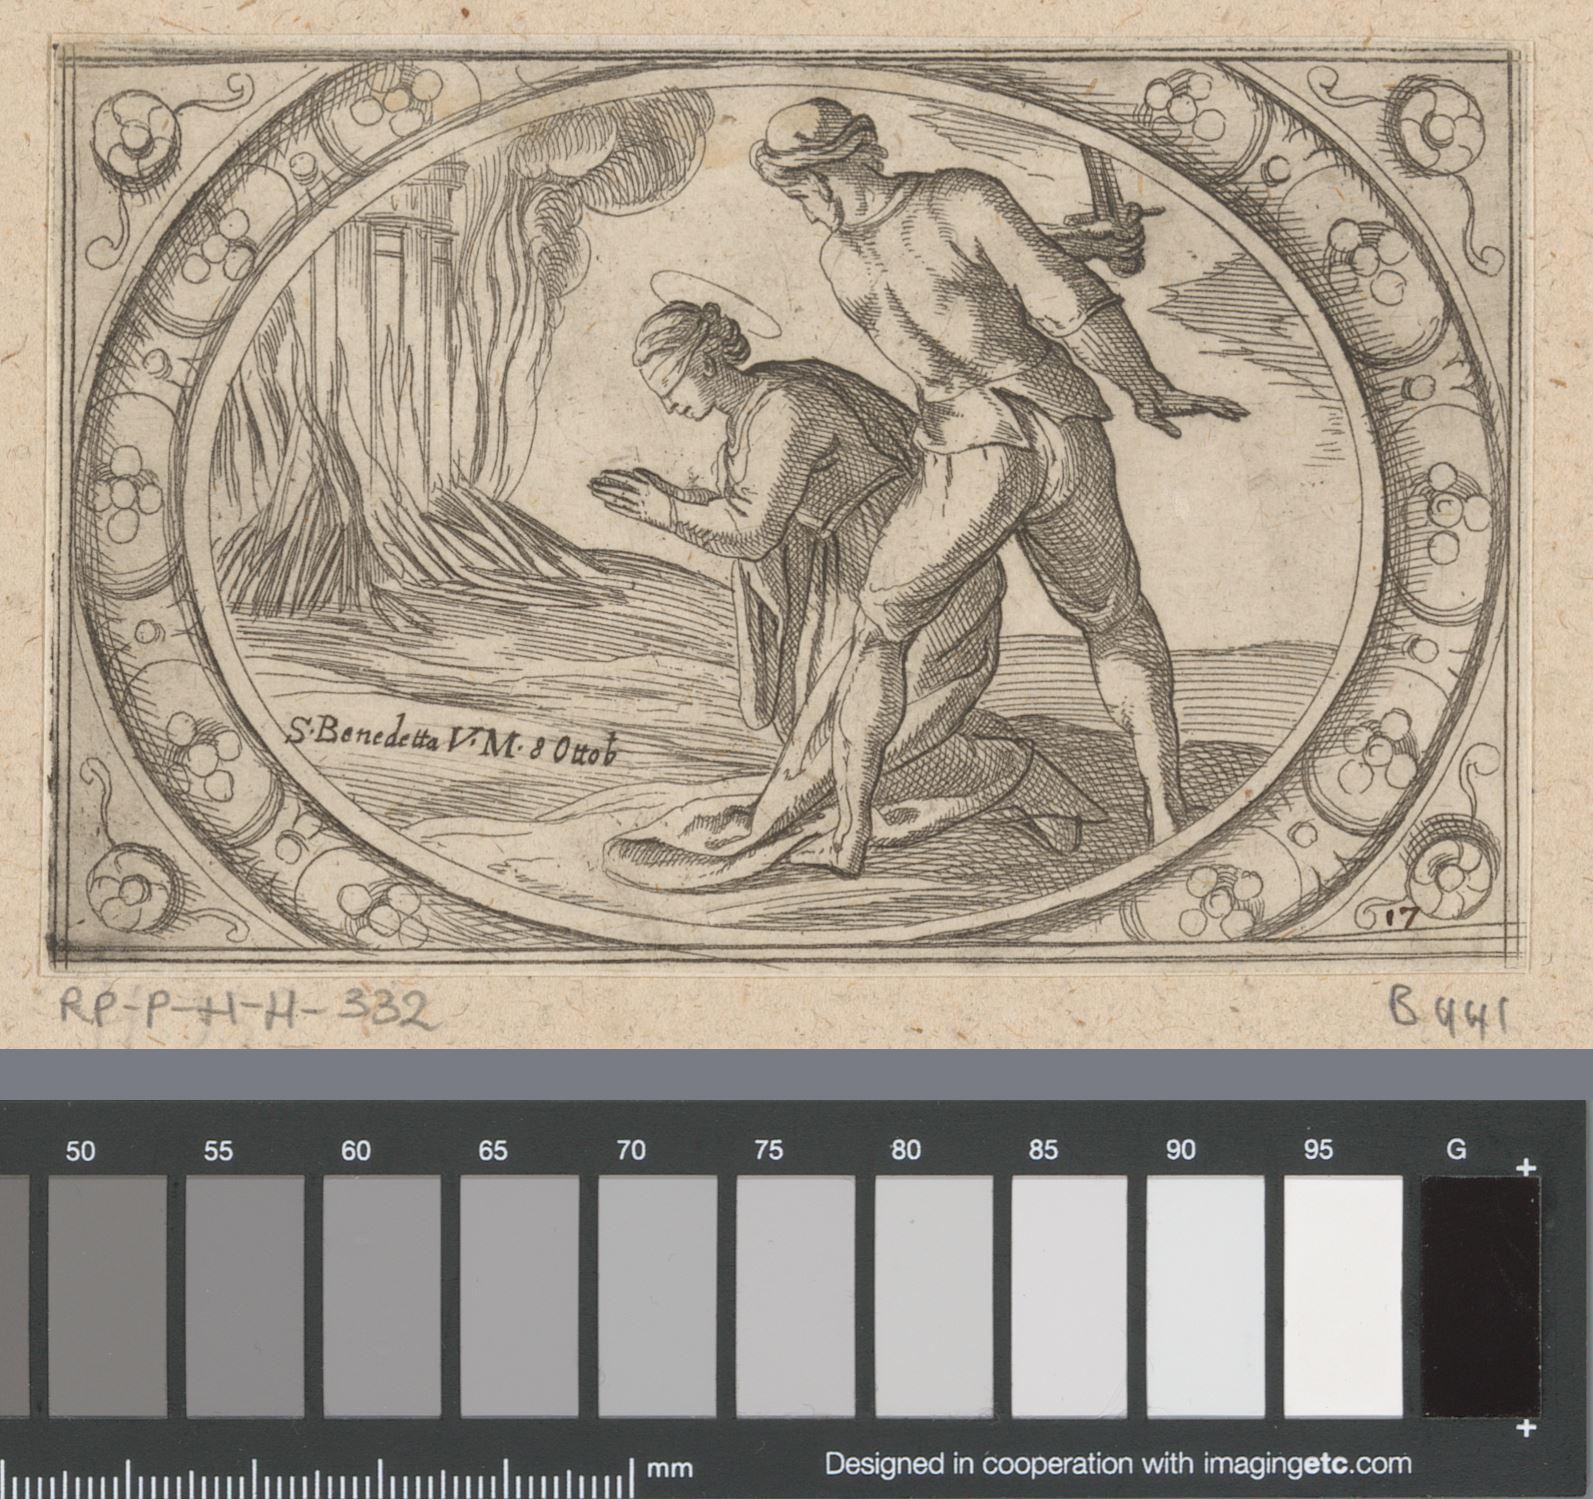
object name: print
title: H. Benedetta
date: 1565-1630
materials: paper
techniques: etching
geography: rome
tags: martyr(s) (often with palm-branches) - qq - female martyr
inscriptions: number: ‘17’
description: Deze prent maakt deel uit van een reeks van 73 prenten (+ titelprent) met voorstellingen van Romeinse martelaressen.